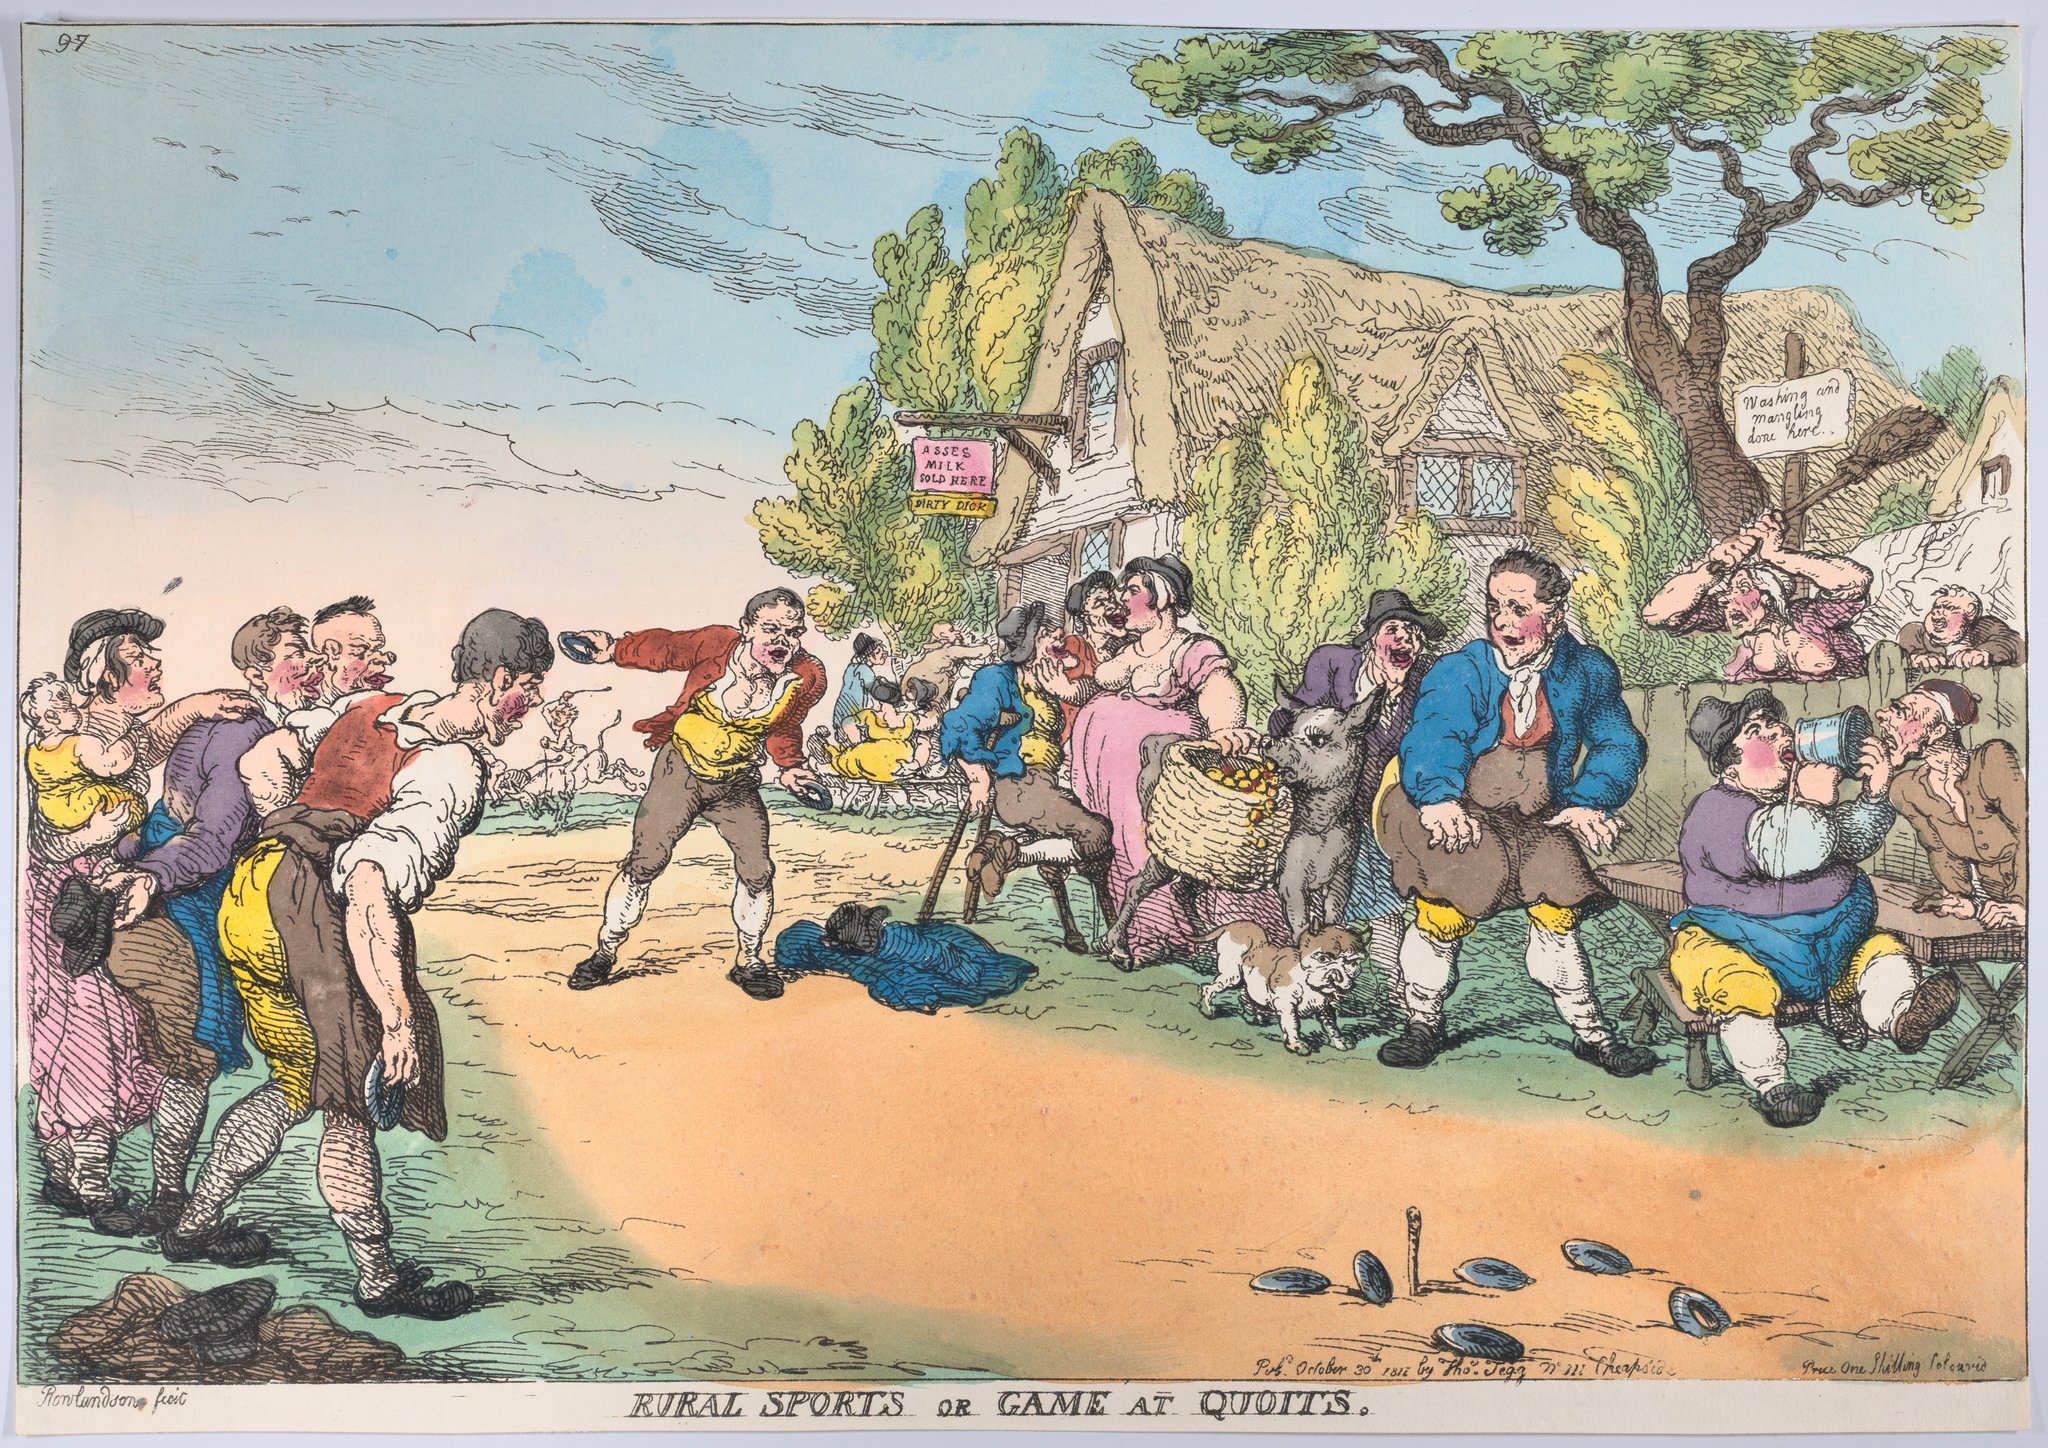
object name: print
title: Rural Sports or Game at Quoits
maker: thomas rowlandson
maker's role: artist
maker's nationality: british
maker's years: 1757-1827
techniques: etching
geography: london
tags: satire,men,women,games